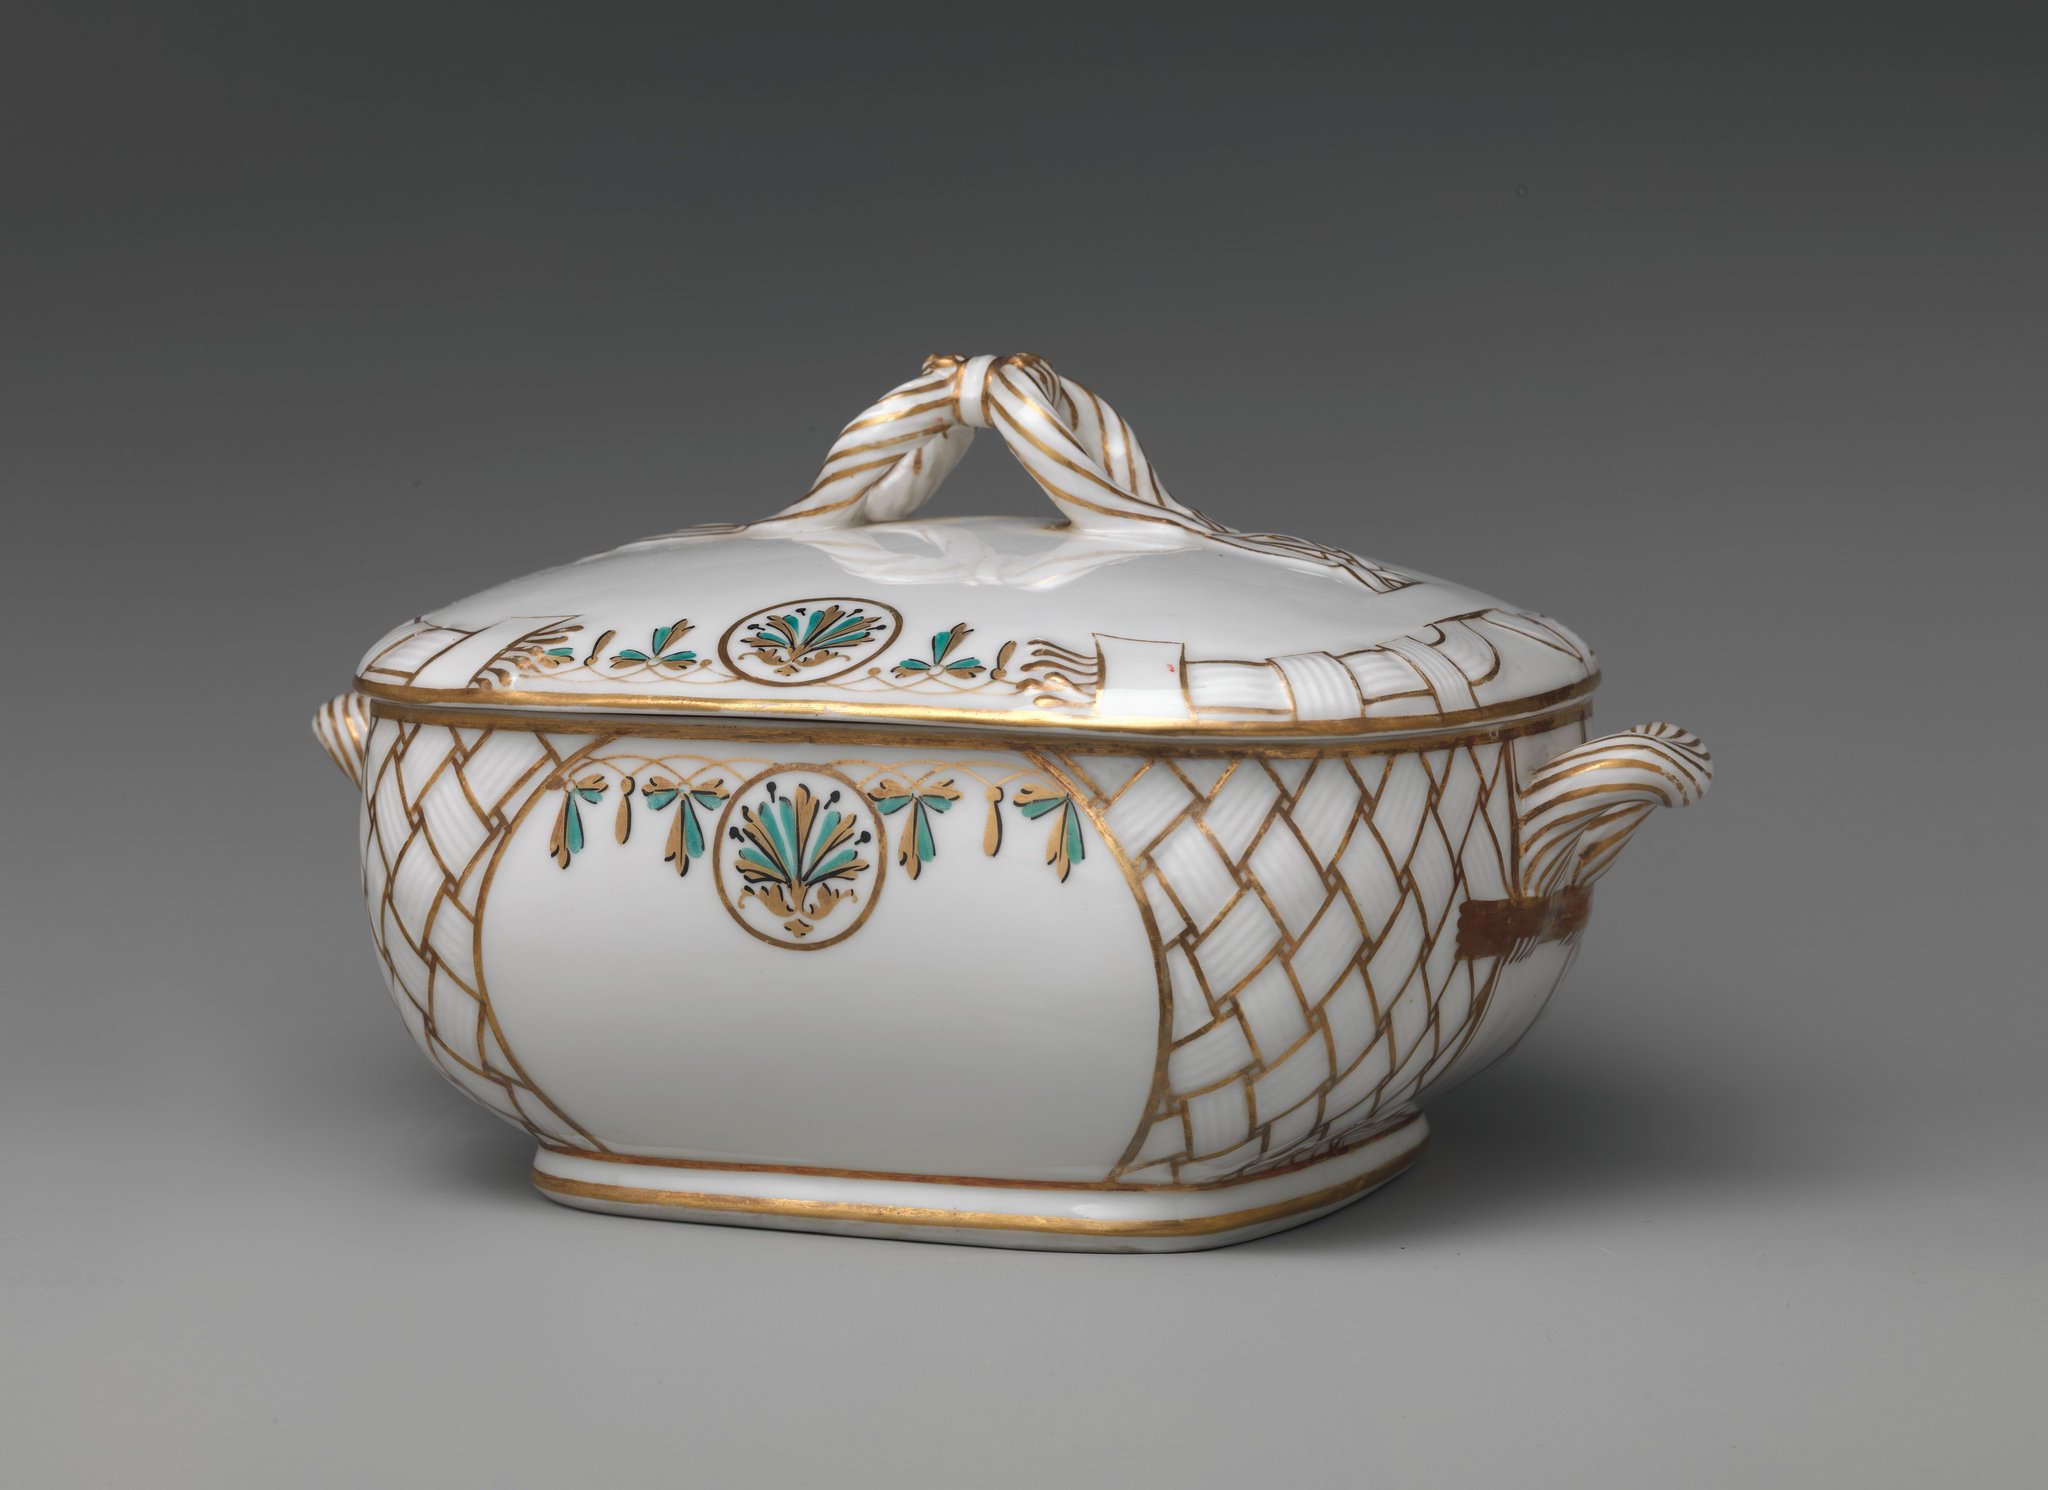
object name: vegetable dish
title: Covered Vegetable Dish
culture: american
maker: union porcelain works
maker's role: maker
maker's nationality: american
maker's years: 1863-1922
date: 1885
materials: porcelain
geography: united states